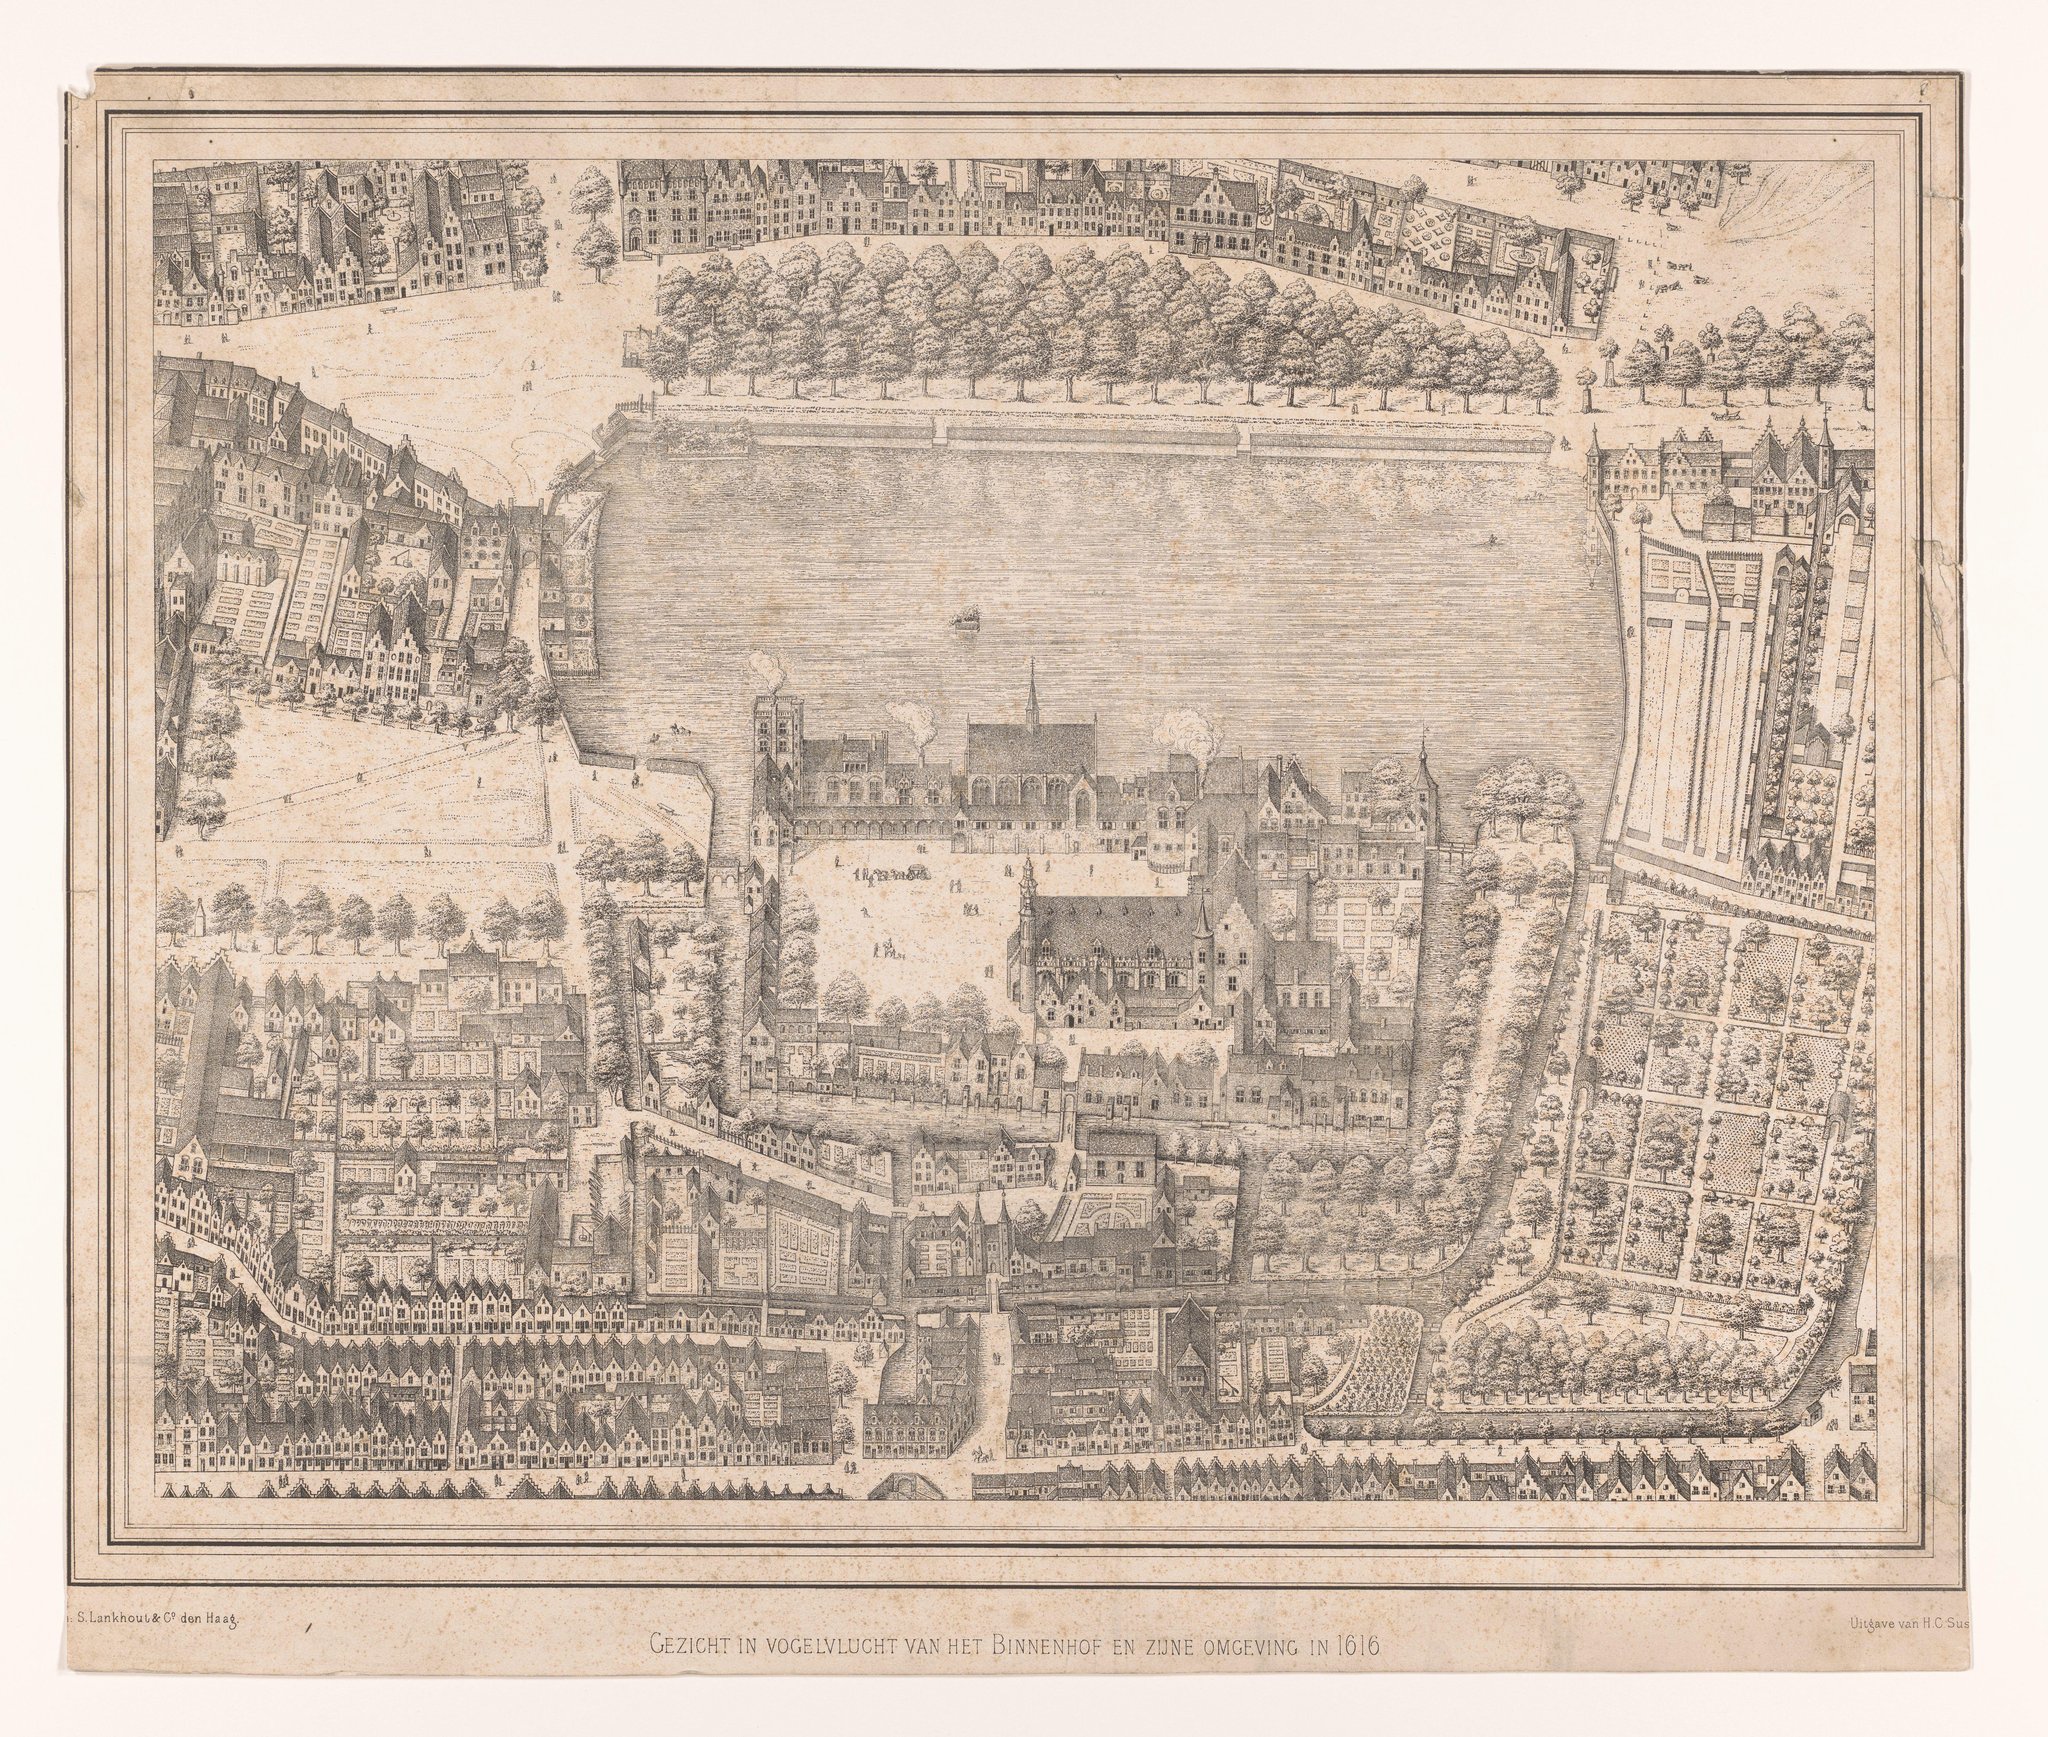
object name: print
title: Gezicht in vogelvlucht op het Binnenhof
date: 1879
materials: paper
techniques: etching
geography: the hague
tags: national government